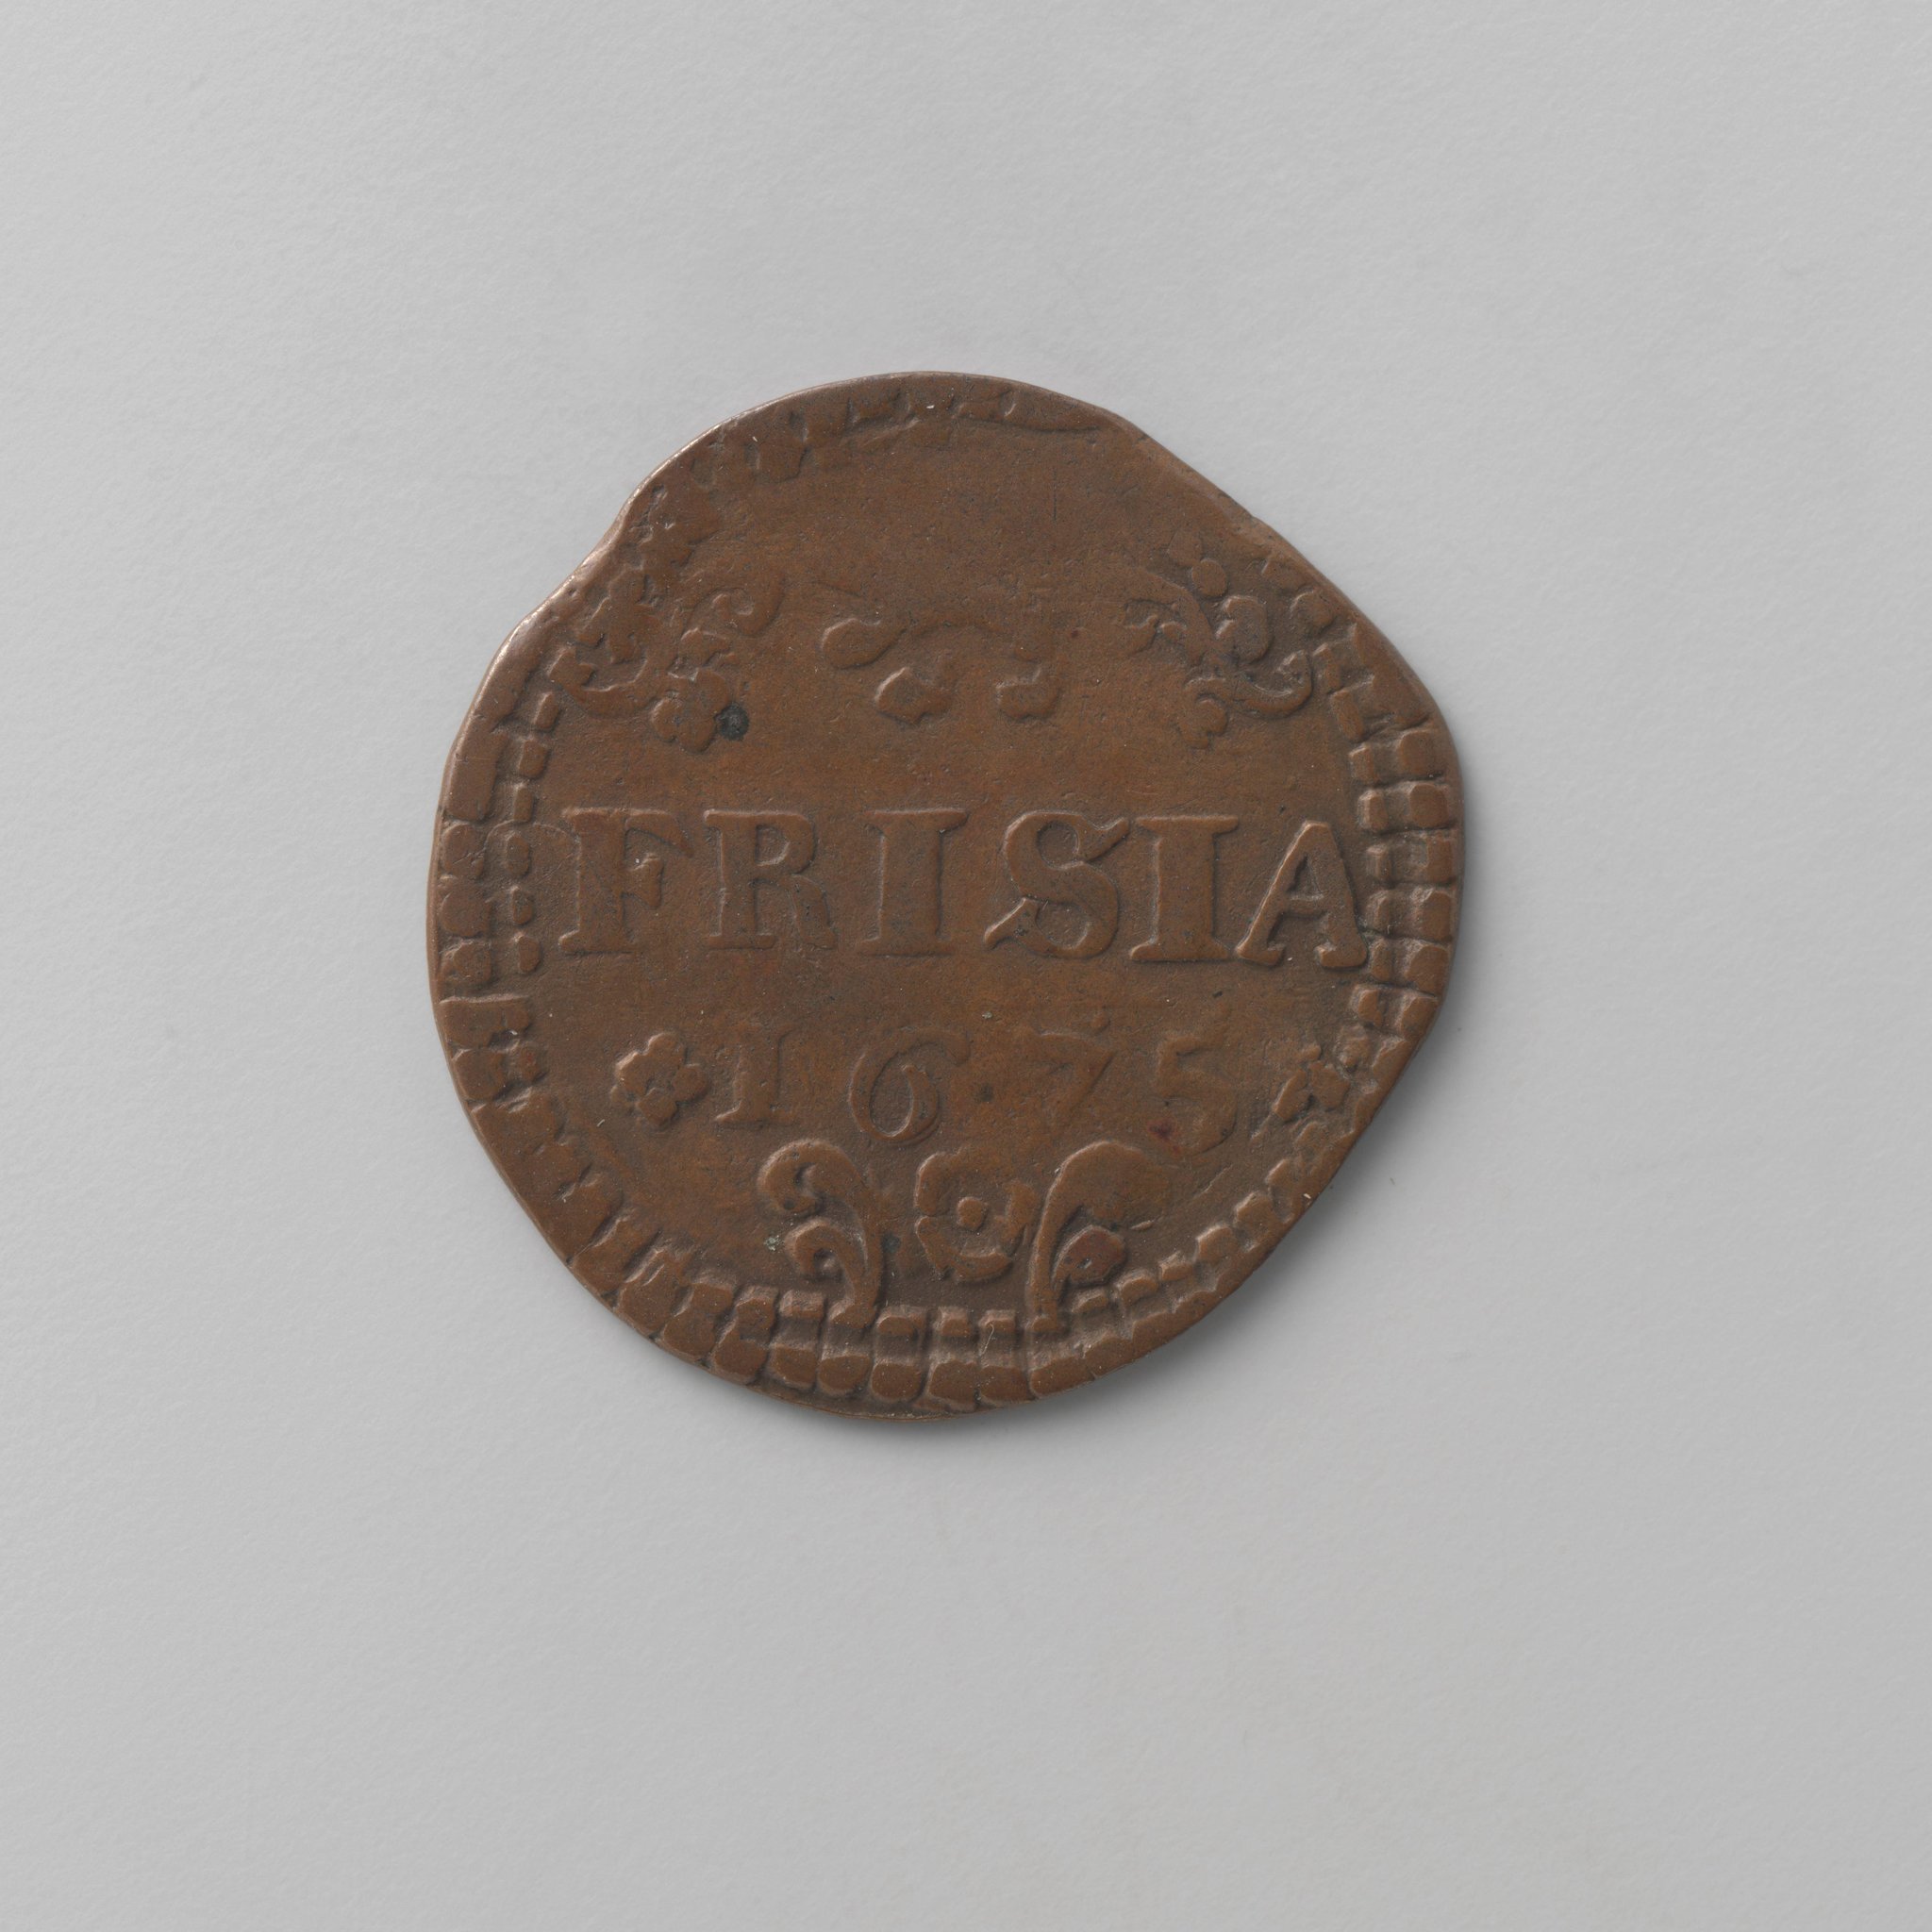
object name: coin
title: Duit van Friesland, 1675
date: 1675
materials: copper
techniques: striking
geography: leeuwarden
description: Koperen munt. Voorzijde: gekroond en versierd wapenschild van Friesland. Keerzijde: muntteken tussen guirlandes, daaronder opschrift in een regel, waaronder jaartal. Daaronder rozet tussen twee guirlandes.